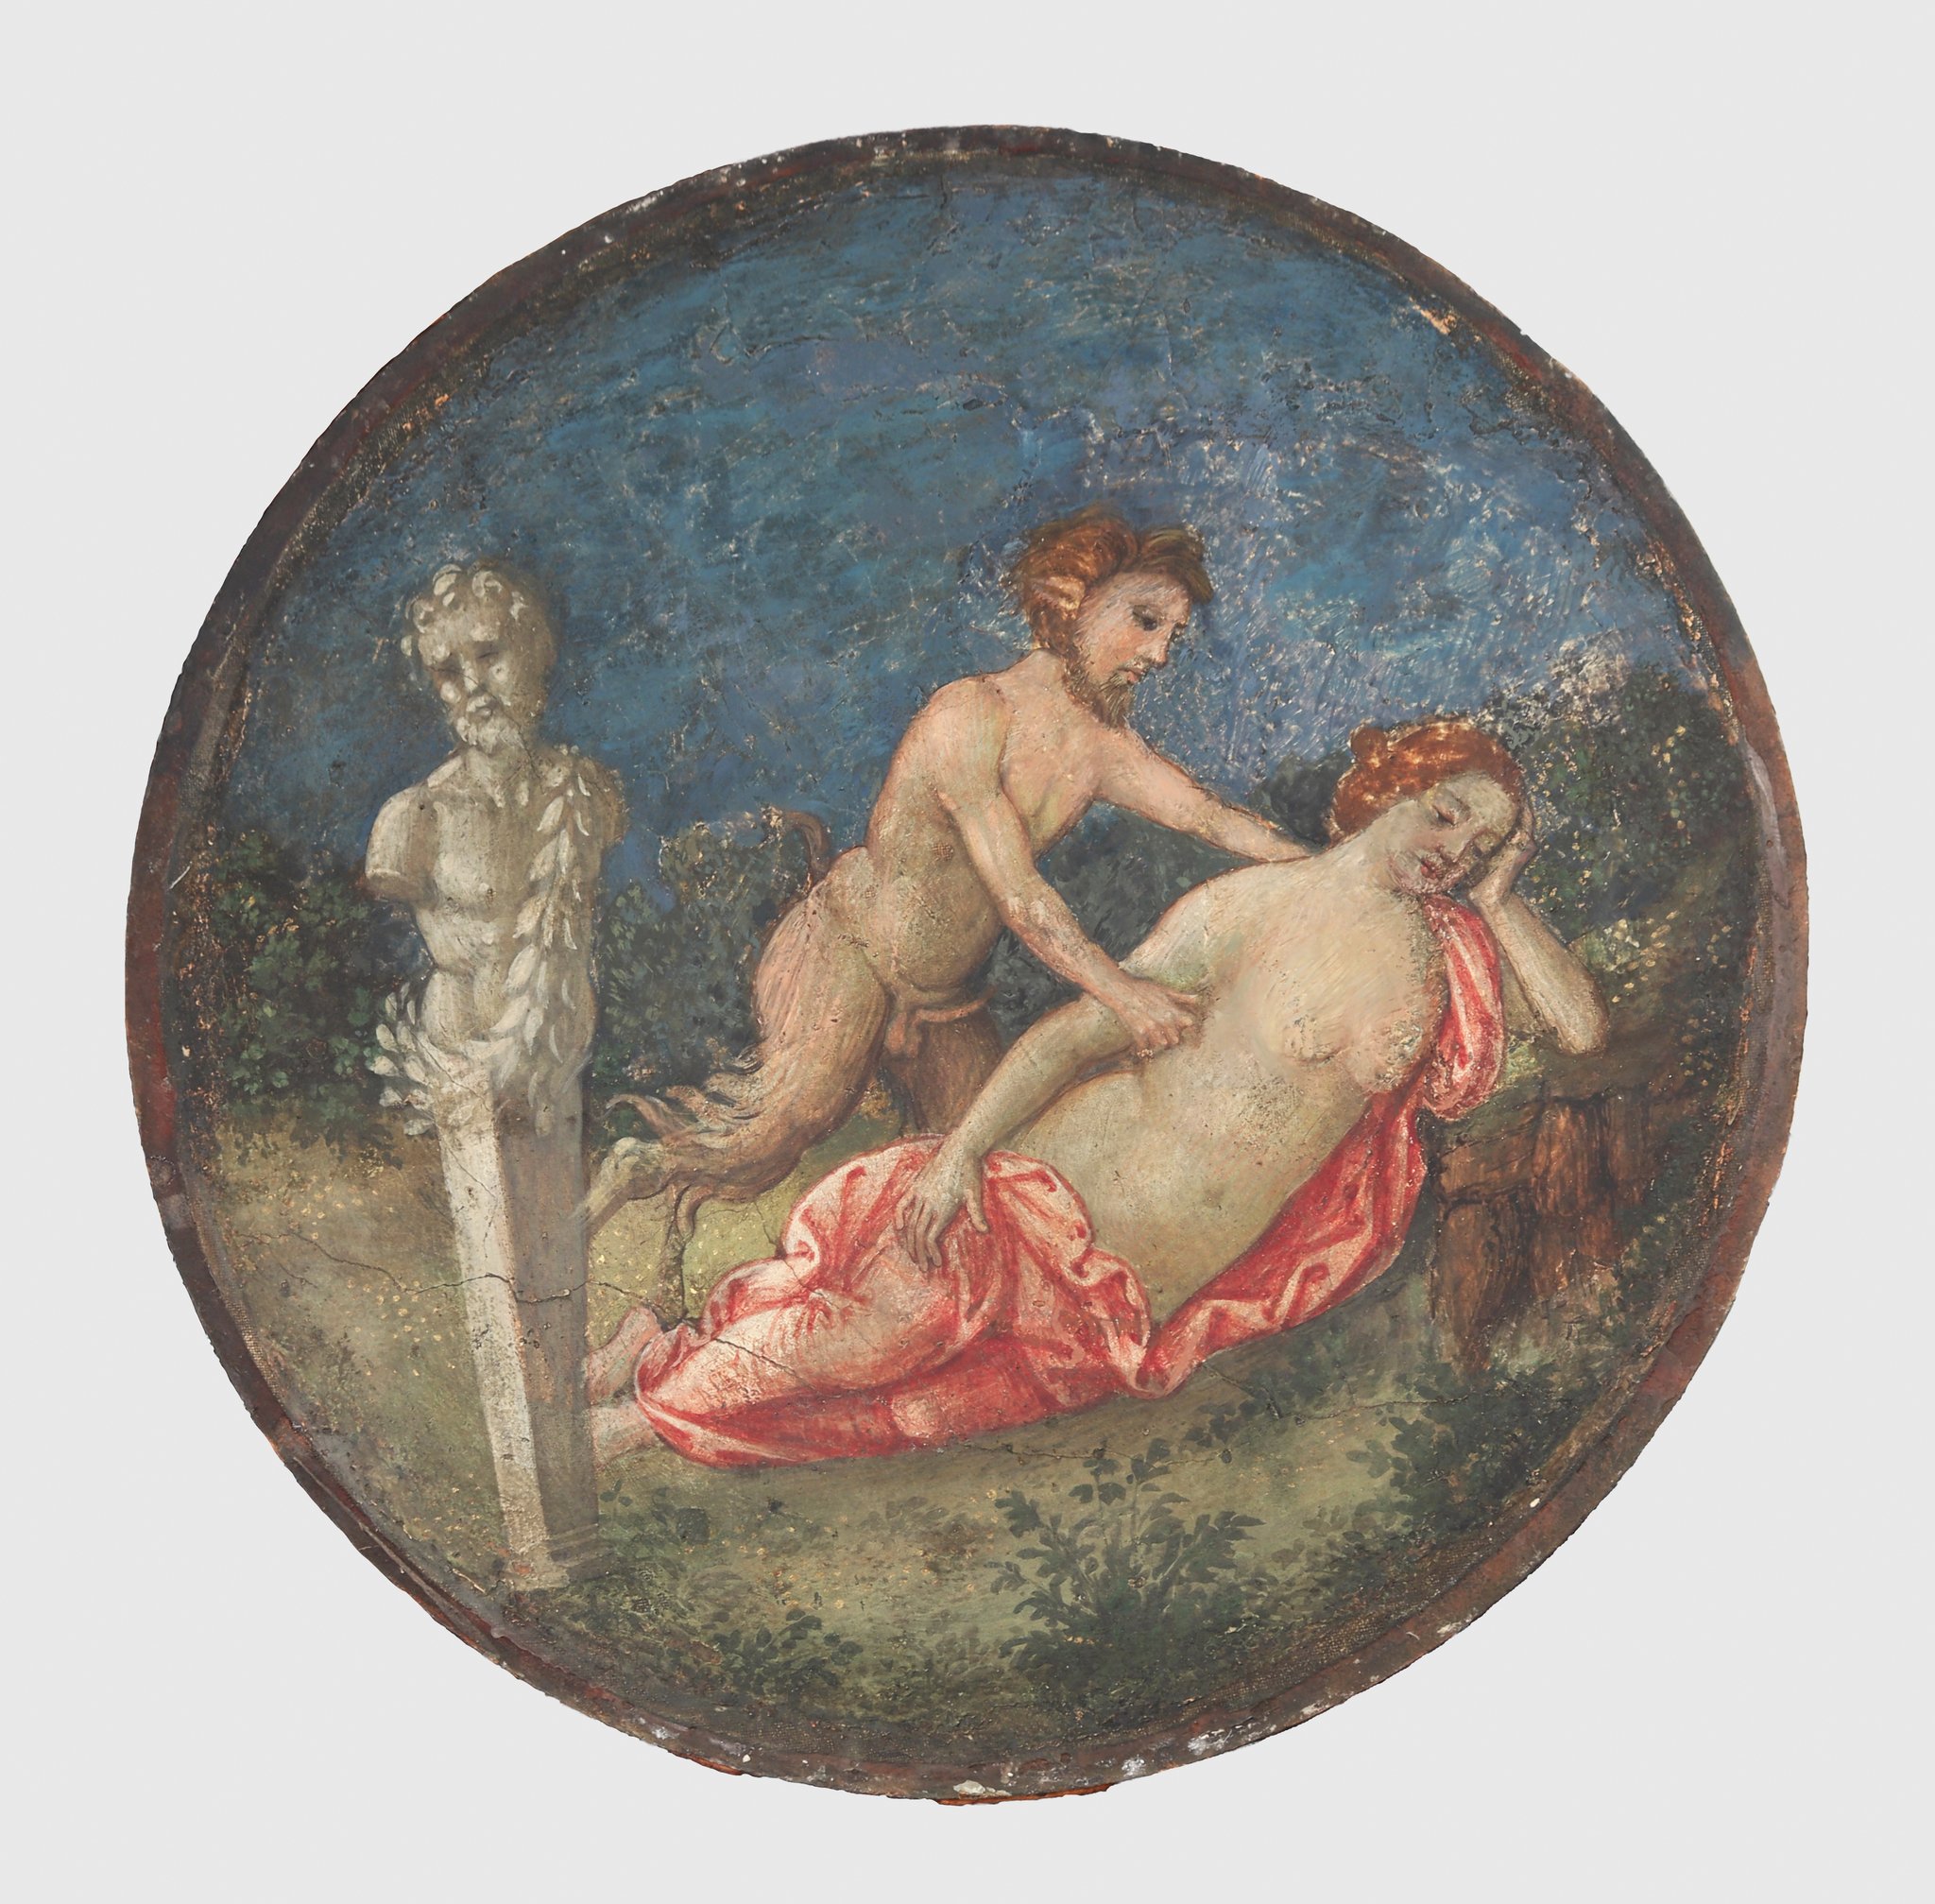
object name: ceiling panel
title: Jupiter and Antiope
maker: pinturicchio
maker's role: artist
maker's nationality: italian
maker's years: 1454-1513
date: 1509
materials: canvas, panel, wood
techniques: fresco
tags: female nudes,jupiter